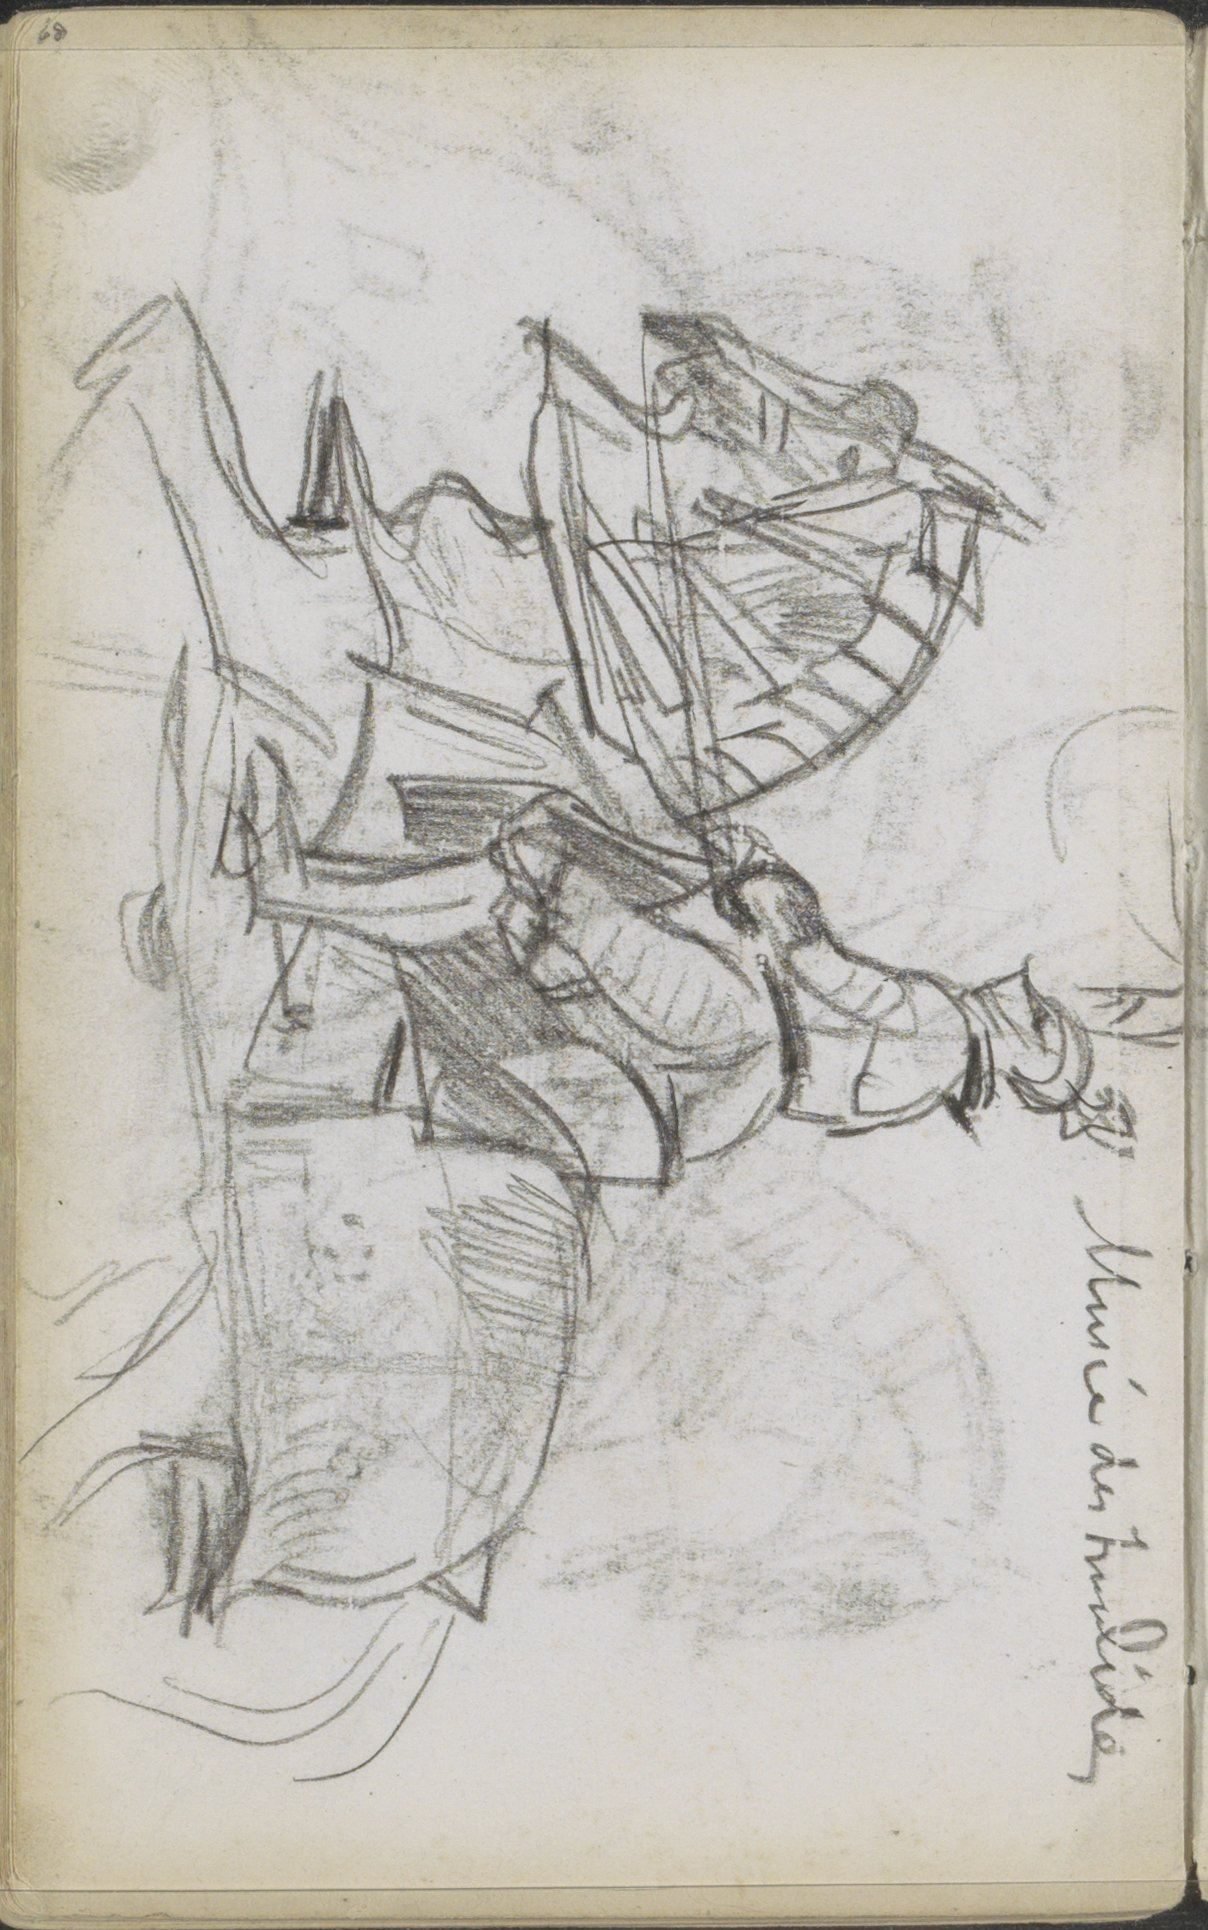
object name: sketchbook leaf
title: Ridder te paard in harnas uit het Musée des Invalides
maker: marius bauer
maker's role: draughtsman, print maker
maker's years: 1867-1932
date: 1810-1891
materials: chalk, paper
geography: paris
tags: helmet, riding a horse, ass, or mule; rider, horseman, armour, knight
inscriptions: annotation: ‘Musée des Invalides’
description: Bauer tekende naar de beelden van ridders in harnas die tentoongesteld waren in het museum, dat gewijd is aan de militaire geschiedenis van Frankrijk. Pagina 68 uit een schetsboek met 35 bladen.